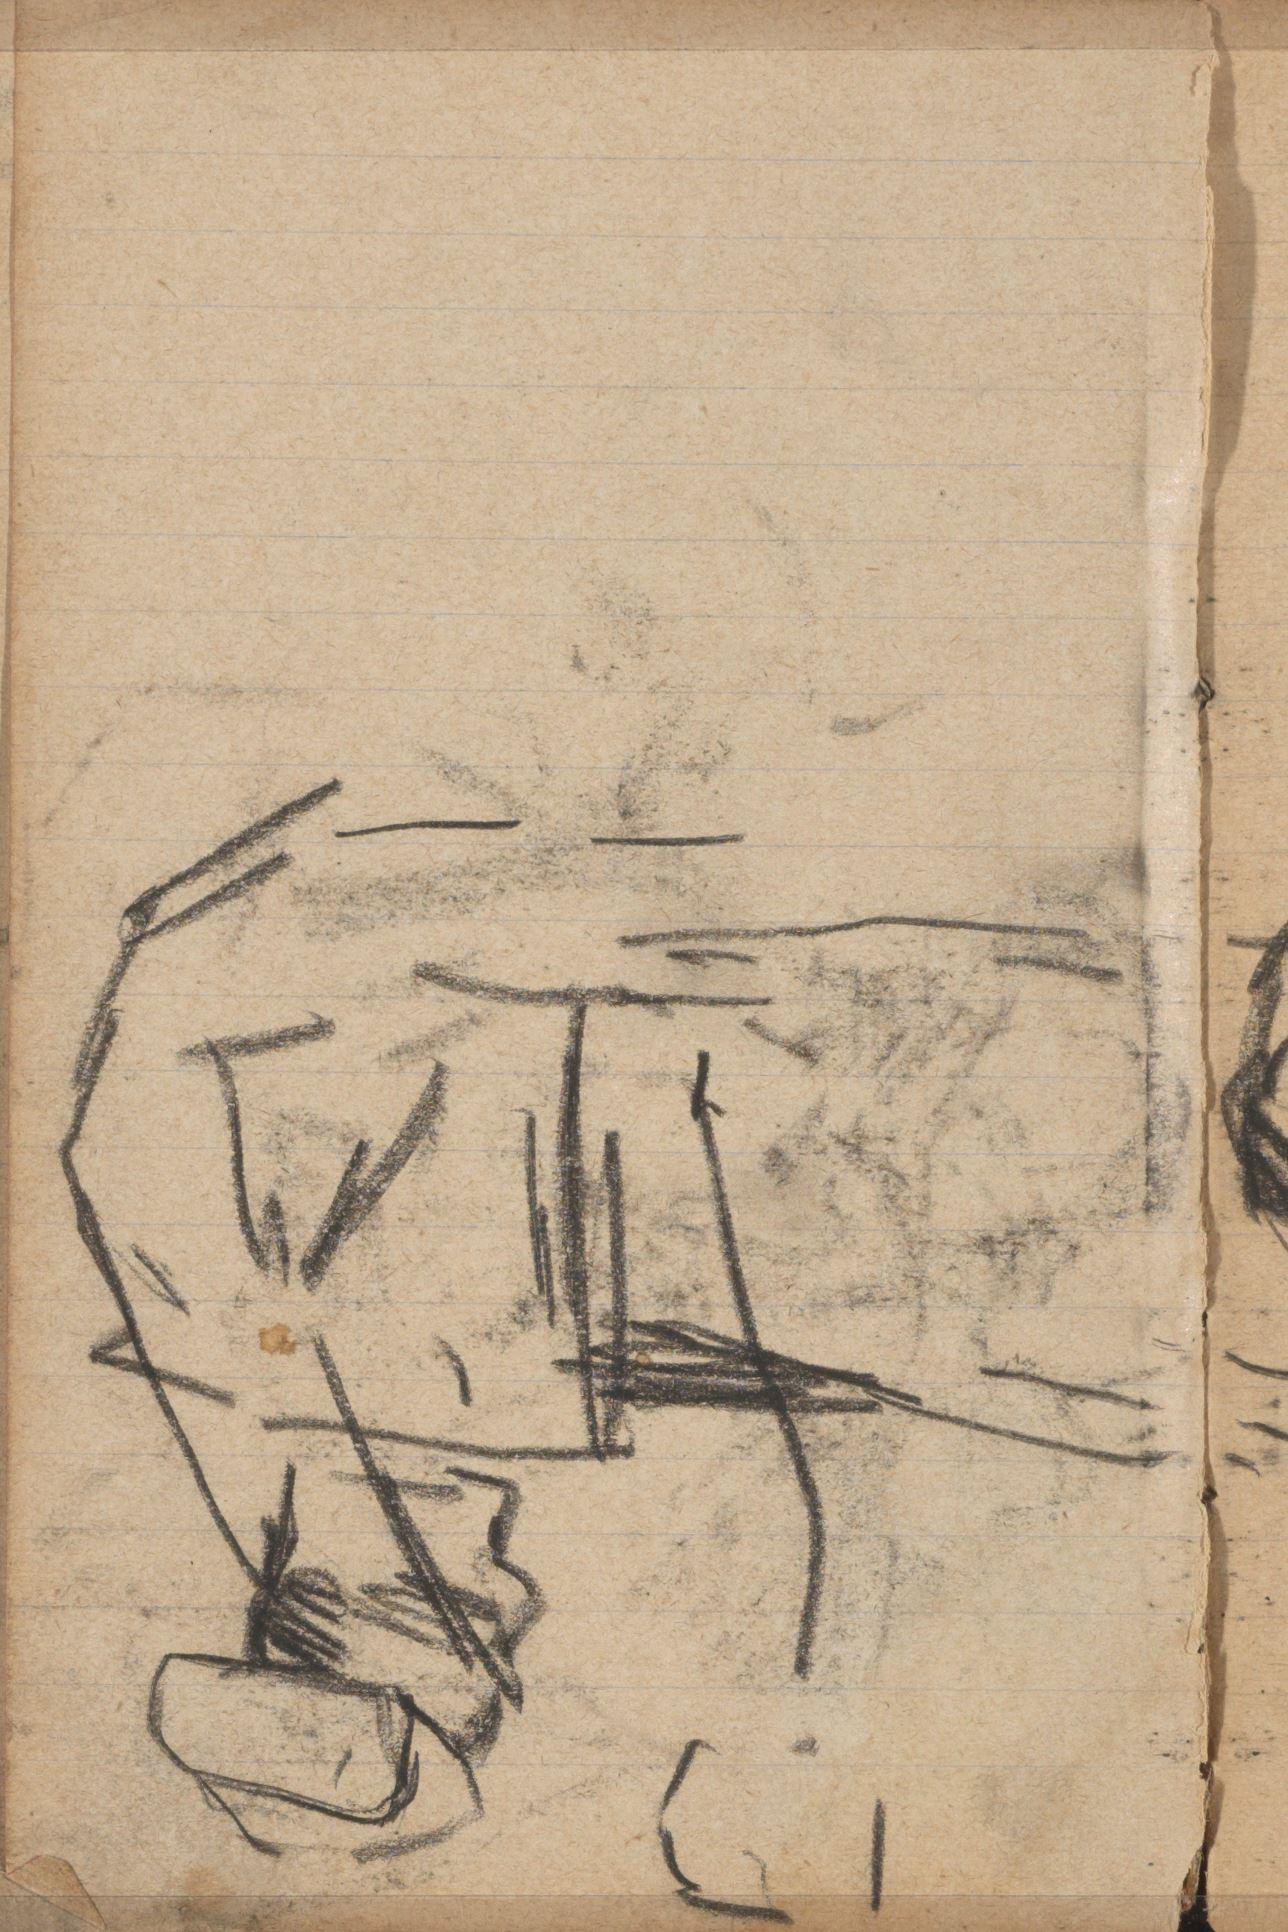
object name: sketchbook leaf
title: Buigende figuur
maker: george hendrik breitner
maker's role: draughtsman, painter, print maker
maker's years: 1857-1923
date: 1886-1903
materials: chalk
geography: amsterdam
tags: bending figure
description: Pagina 27 uit een schetsboek met 41 bladen.